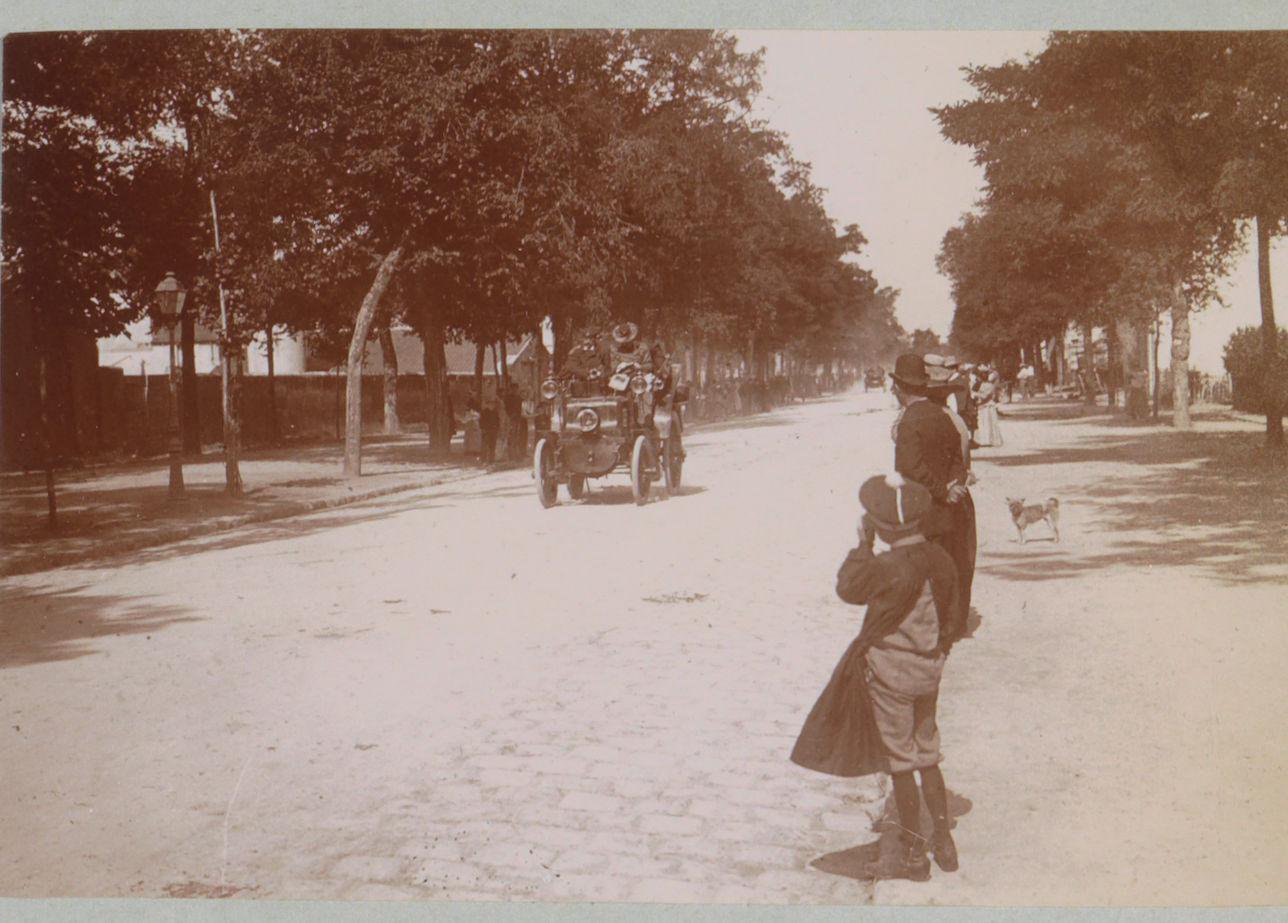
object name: photograph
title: Start van de race Parijs-Amsterdam voor automobielen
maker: delizy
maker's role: manufacturer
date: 1898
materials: paper, photographic support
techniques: gelatin silver print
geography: paris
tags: motorcar racing, automobile, street (+ city(-scape) with figures, staffage), paris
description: Onderdeel van Fotoalbum van een Franse amateurfotograaf met opnames van uitstapjes in Frankrijk, Spanje, België, Luxemburg en Nederland, de eerste automobielen en autoraces.